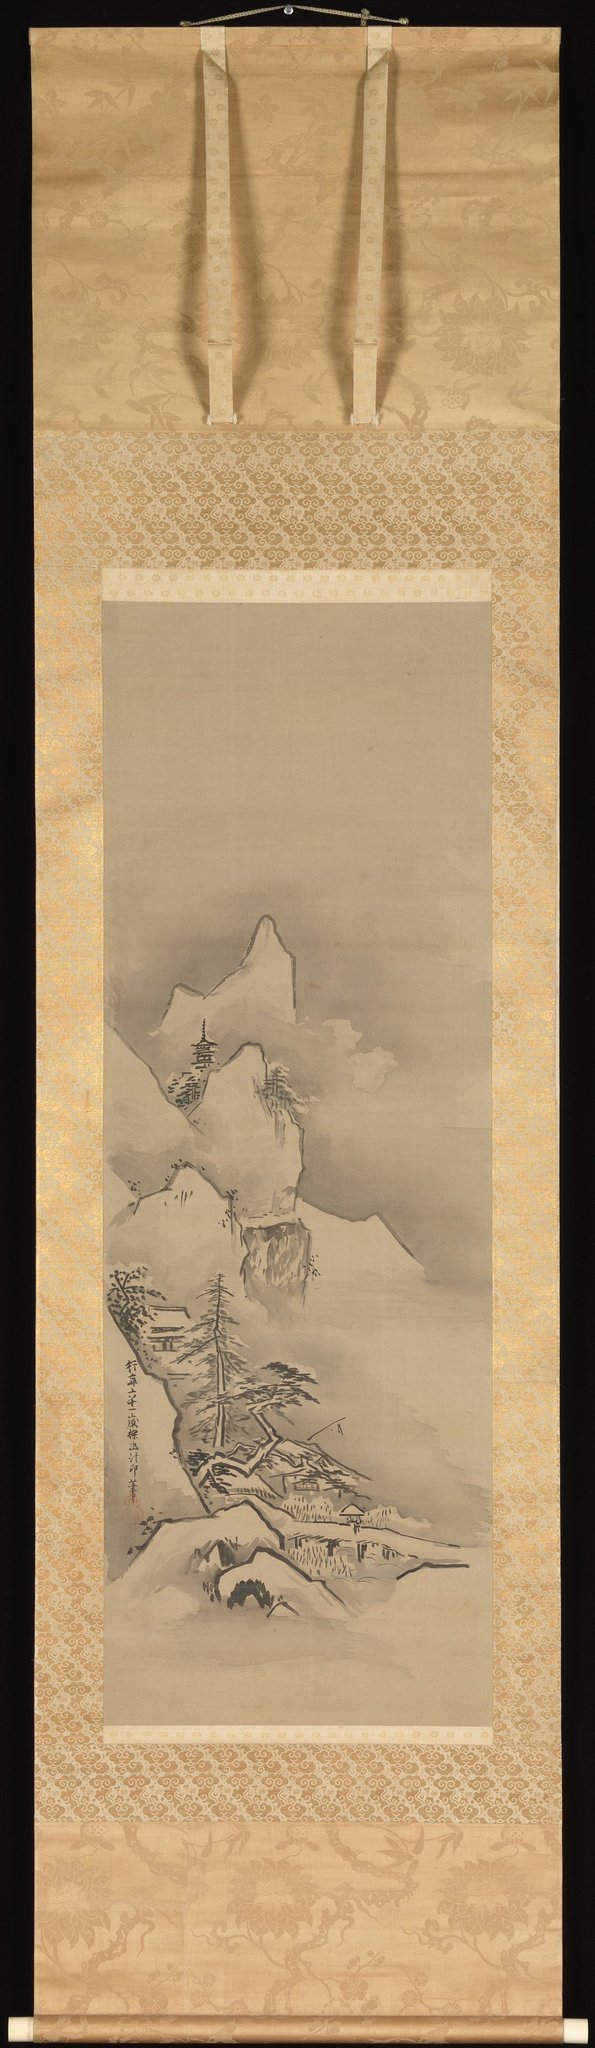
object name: hanging scroll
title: Winter Landscape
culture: japanese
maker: kano tan'yū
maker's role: artist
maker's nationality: japanese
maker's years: 1602-1674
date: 1662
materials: ink, silk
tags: landscapes,snow